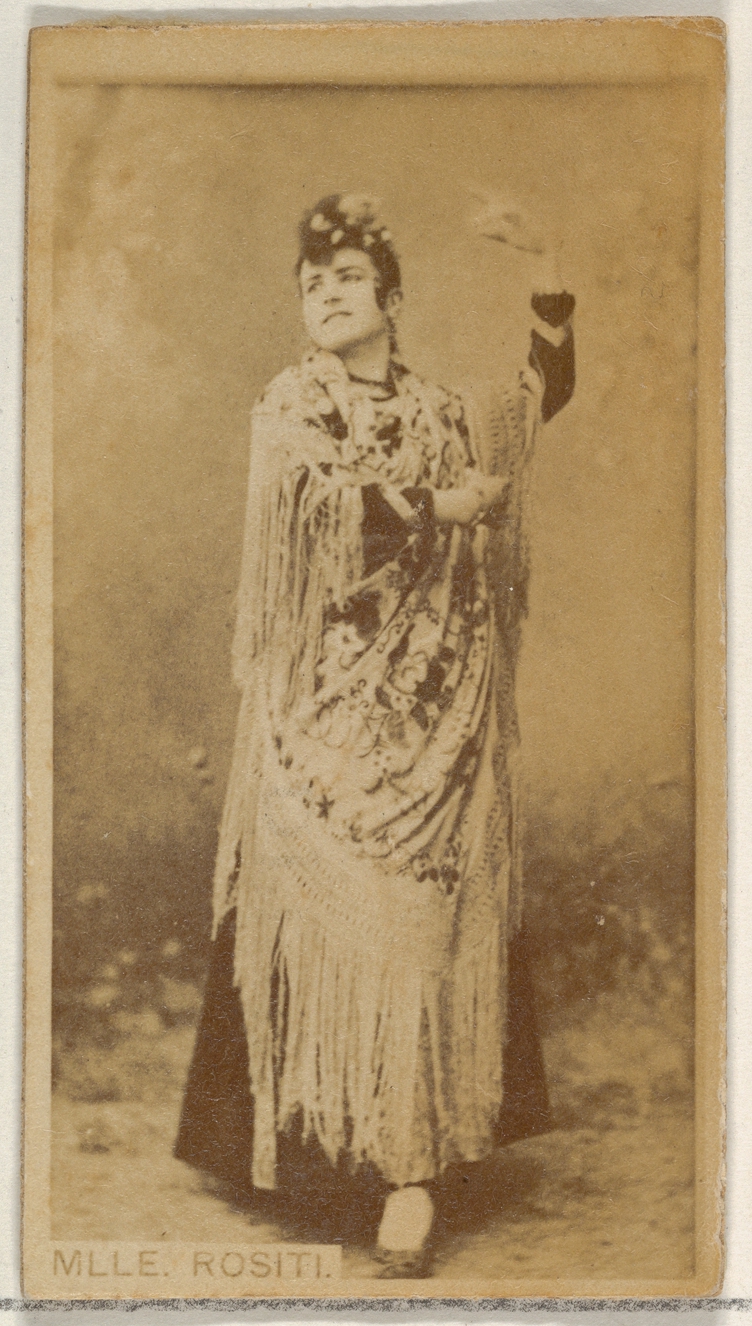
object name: photograph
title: Mlle. Rositi, from the Actors and Actresses series (N45, Type 8) for Virginia Brights Cigarettes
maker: allen & ginter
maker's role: publisher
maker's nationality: american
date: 1888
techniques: albumen silver print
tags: portraits,women,actresses